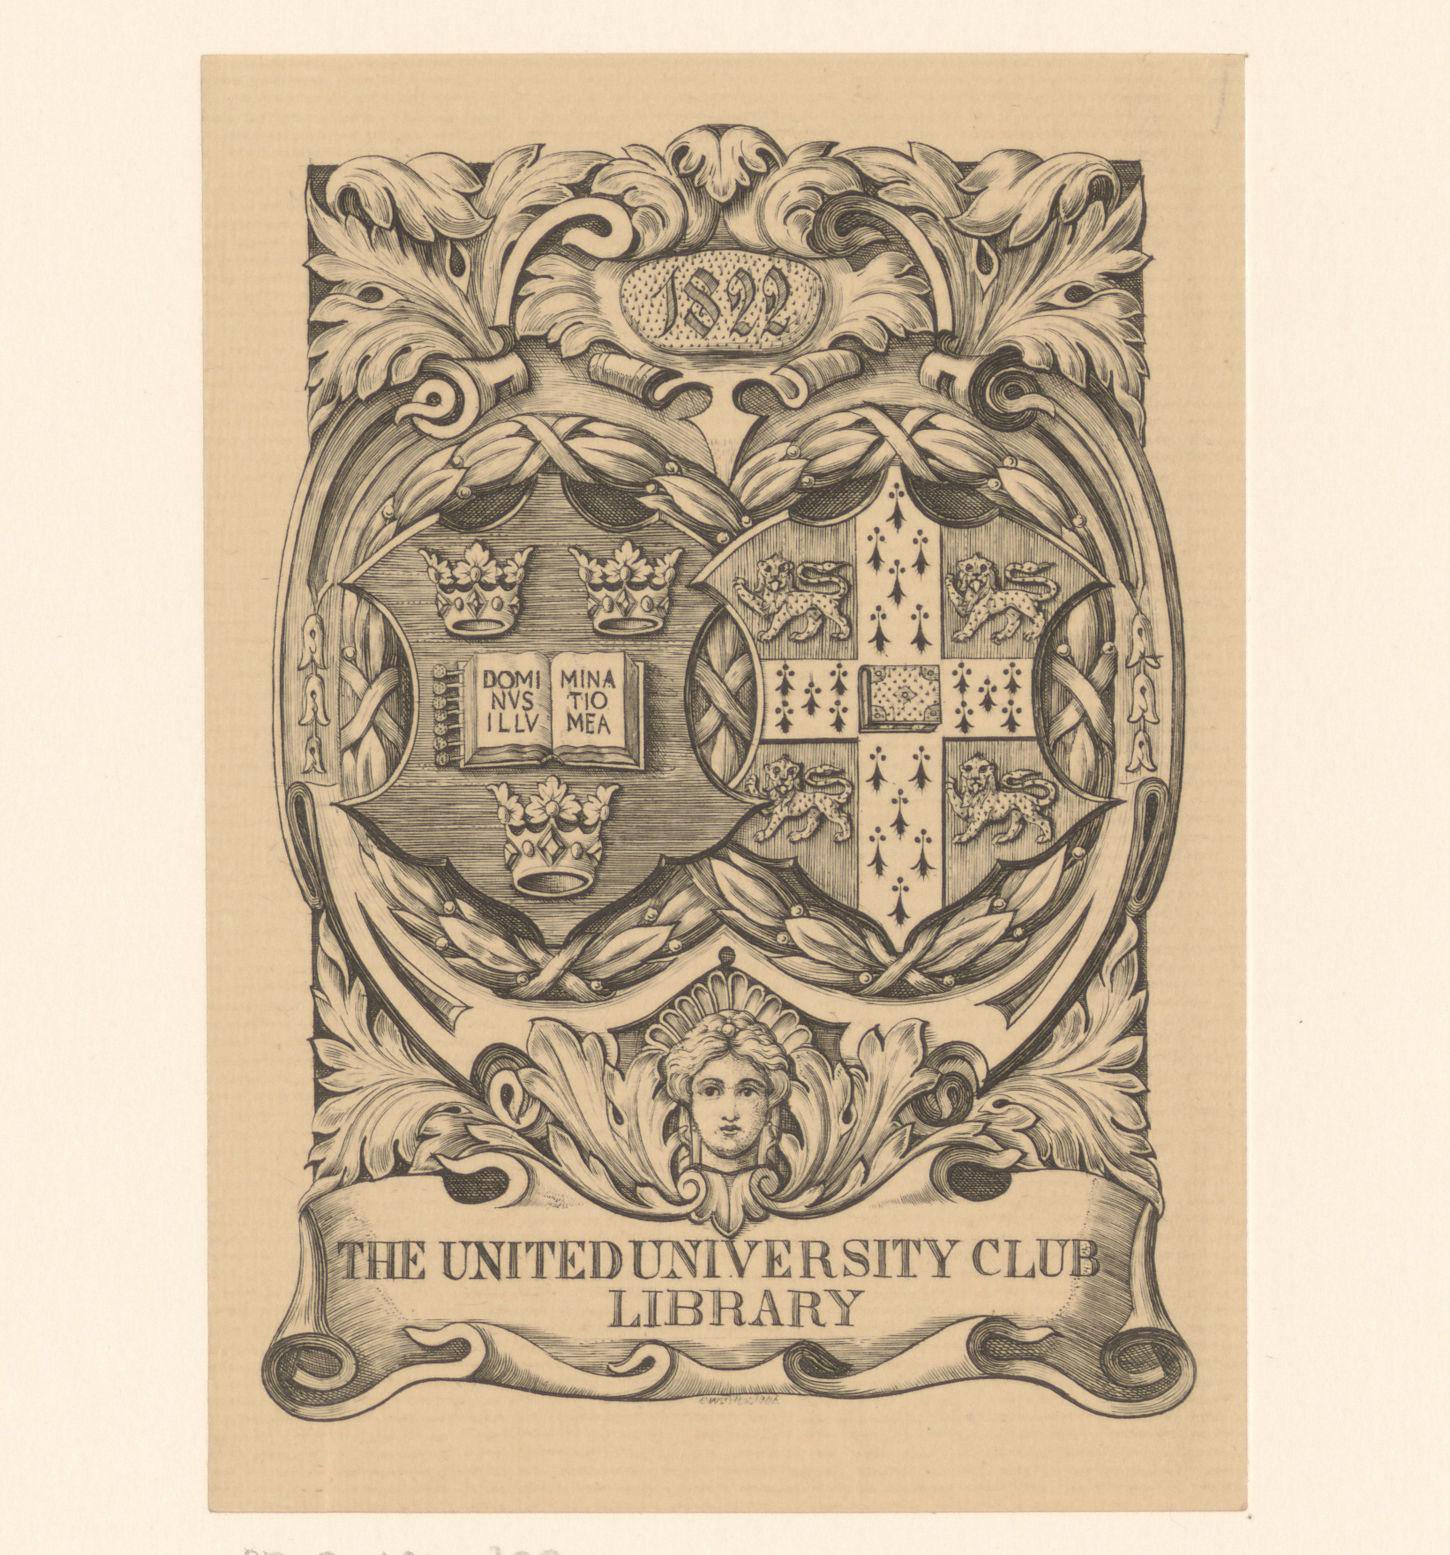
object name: bookplate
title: Ex libris van de United University Club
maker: charles william sherborn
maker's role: print maker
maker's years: 1831-1912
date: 1896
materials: paper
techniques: engraving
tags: foliage ~ ornament, armorial bearing, heraldry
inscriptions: collector's mark: Lugt 2228